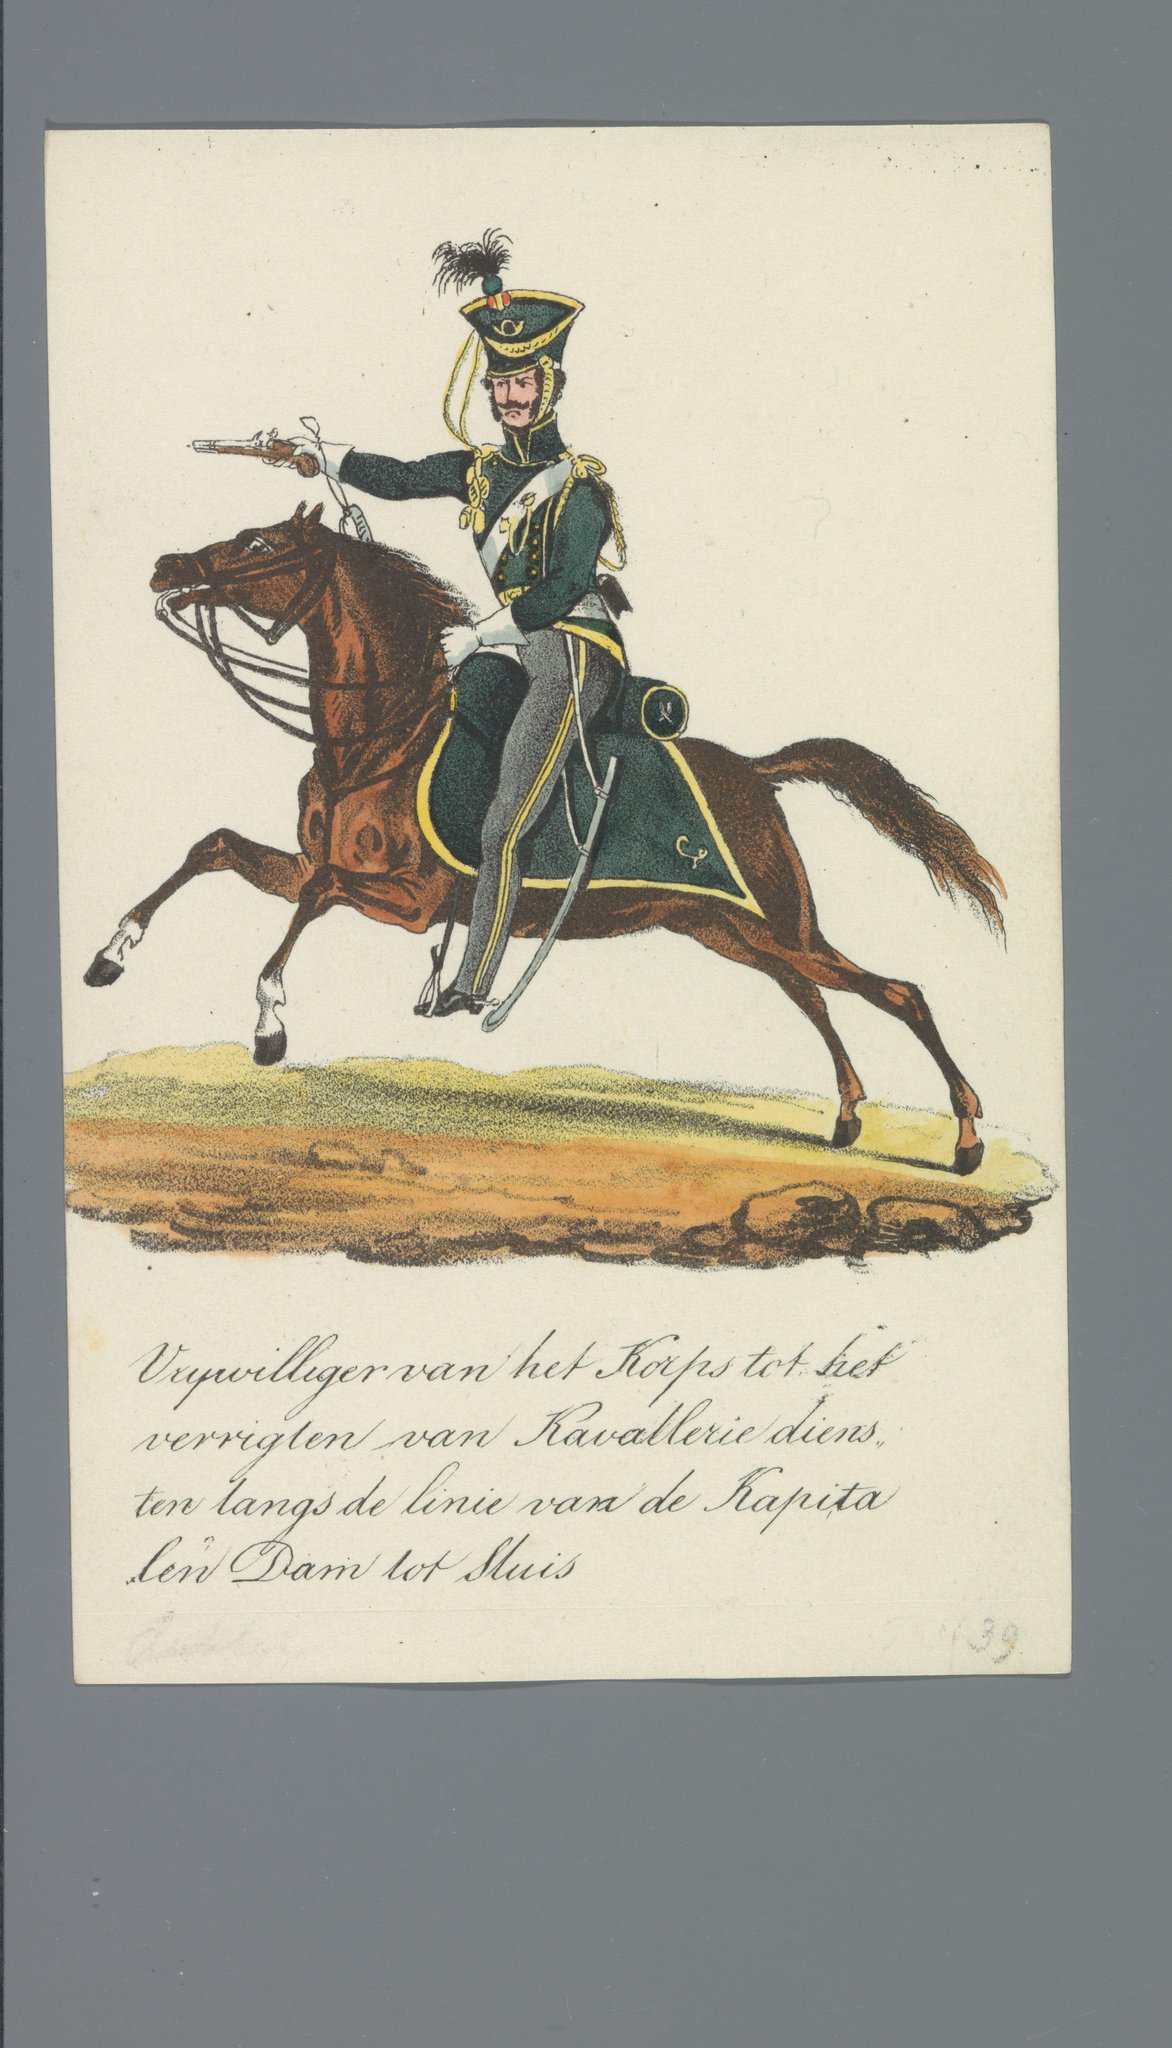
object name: costume print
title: Nederlandse militaire uniformen in de jaren 1830-1832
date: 1835-1850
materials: paper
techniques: hand coloring, lithograph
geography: utrecht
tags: (military) uniforms, clothes, costume, zeeland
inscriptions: collector's mark: Lugt 2228, collector's mark: Lugt 2227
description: Jager te paard, van het Korps Vrijwillige Jagers te Paard in het 4e district van Zeeland. Onderdeel van een serie van 157 losse bladen met Nederlandse militaire uniformen in de jaren 1830-1832.